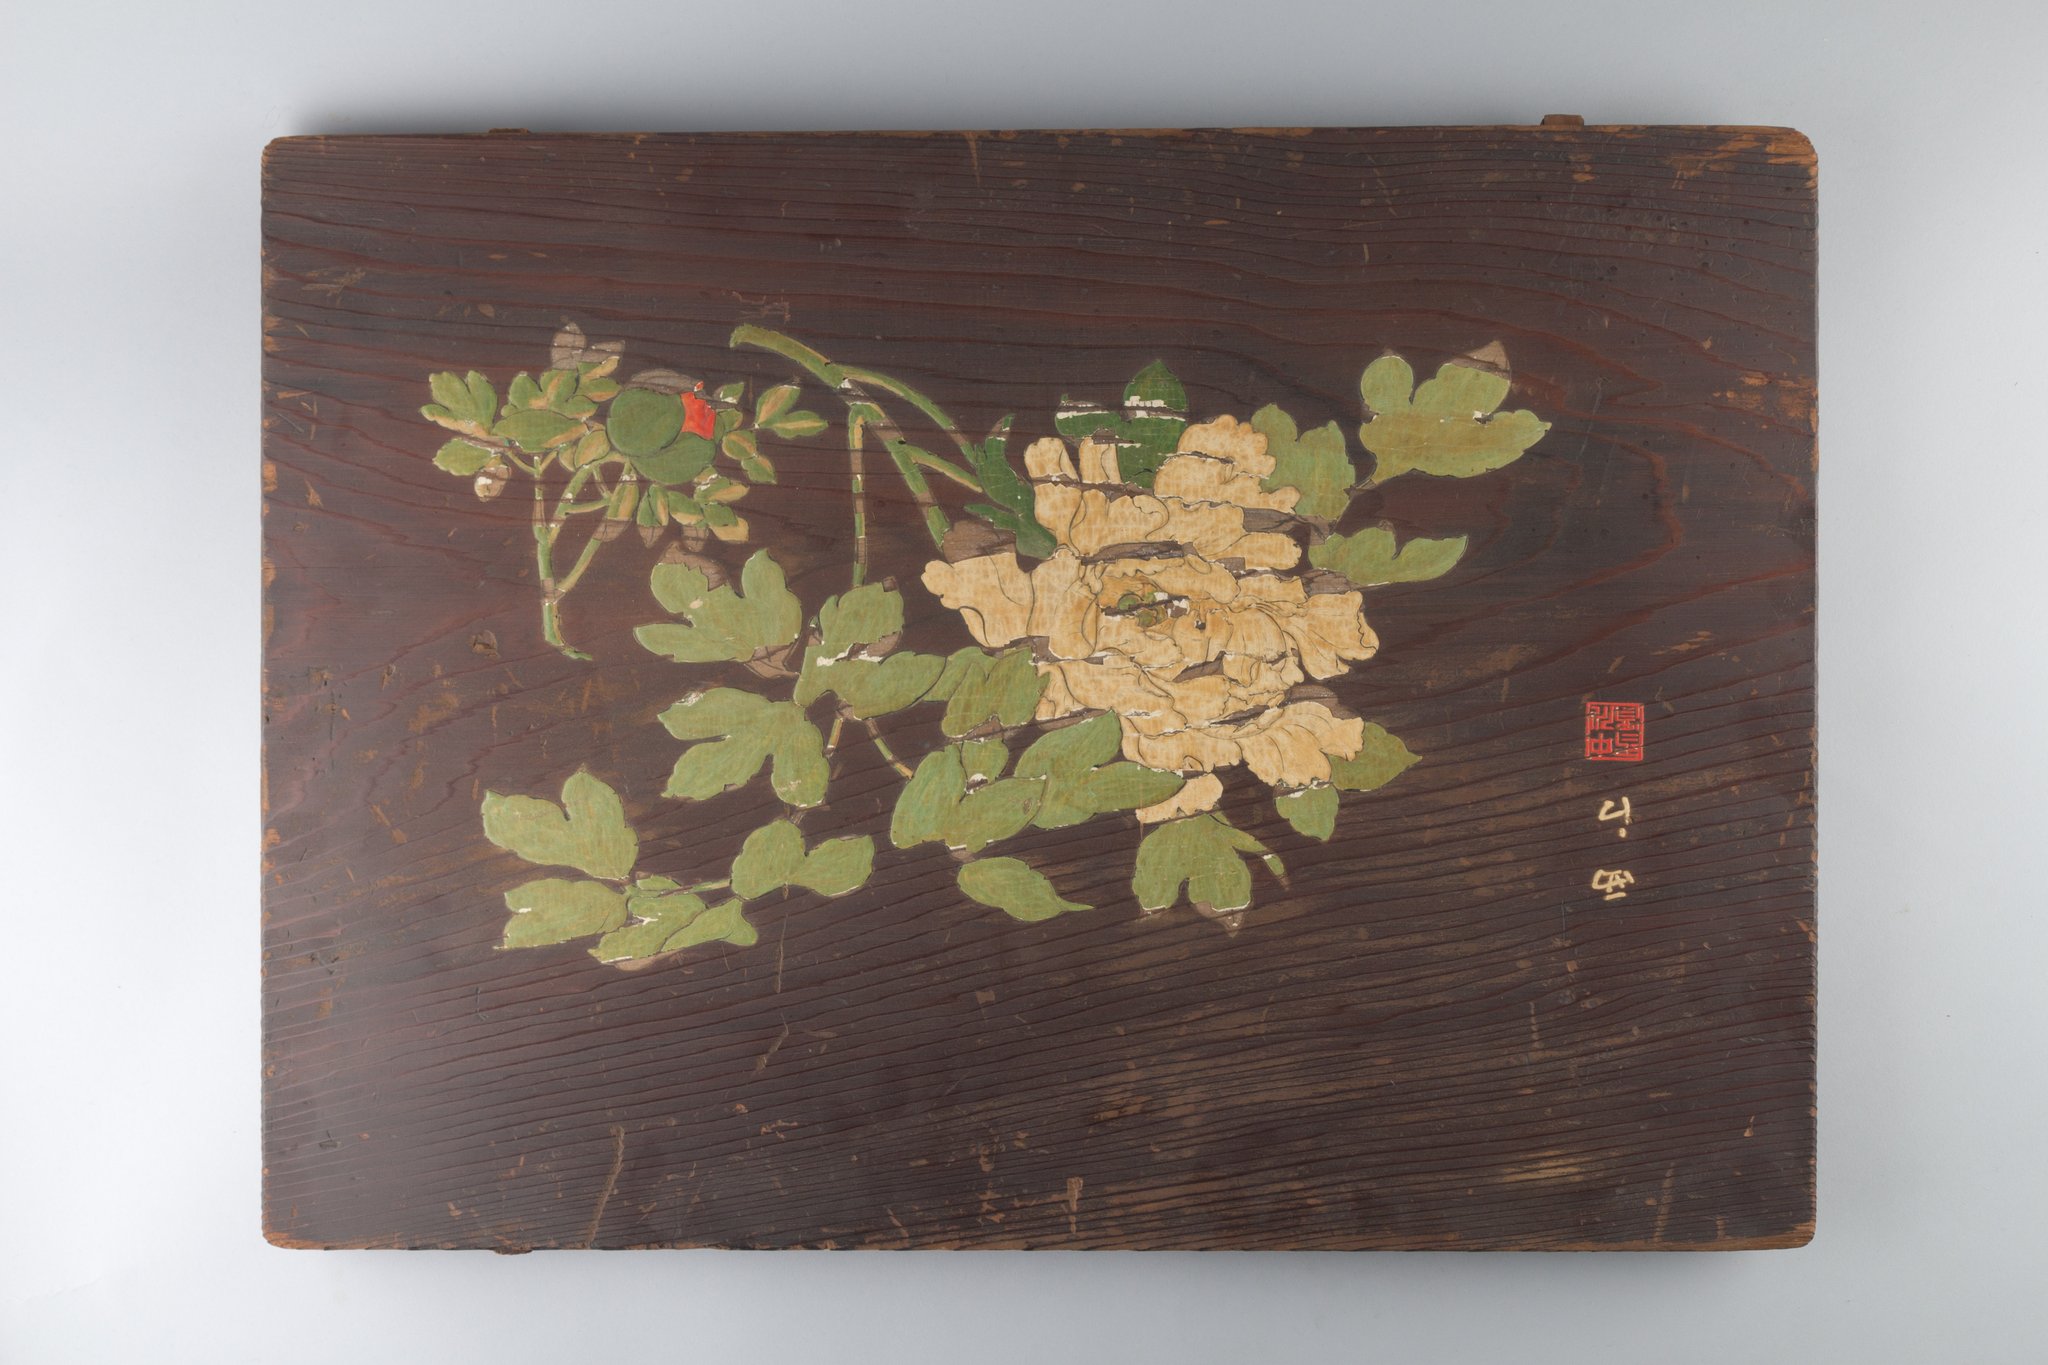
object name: votive plaque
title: Peonies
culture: japanese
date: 1801-1900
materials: ink, shell, wood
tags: peonies